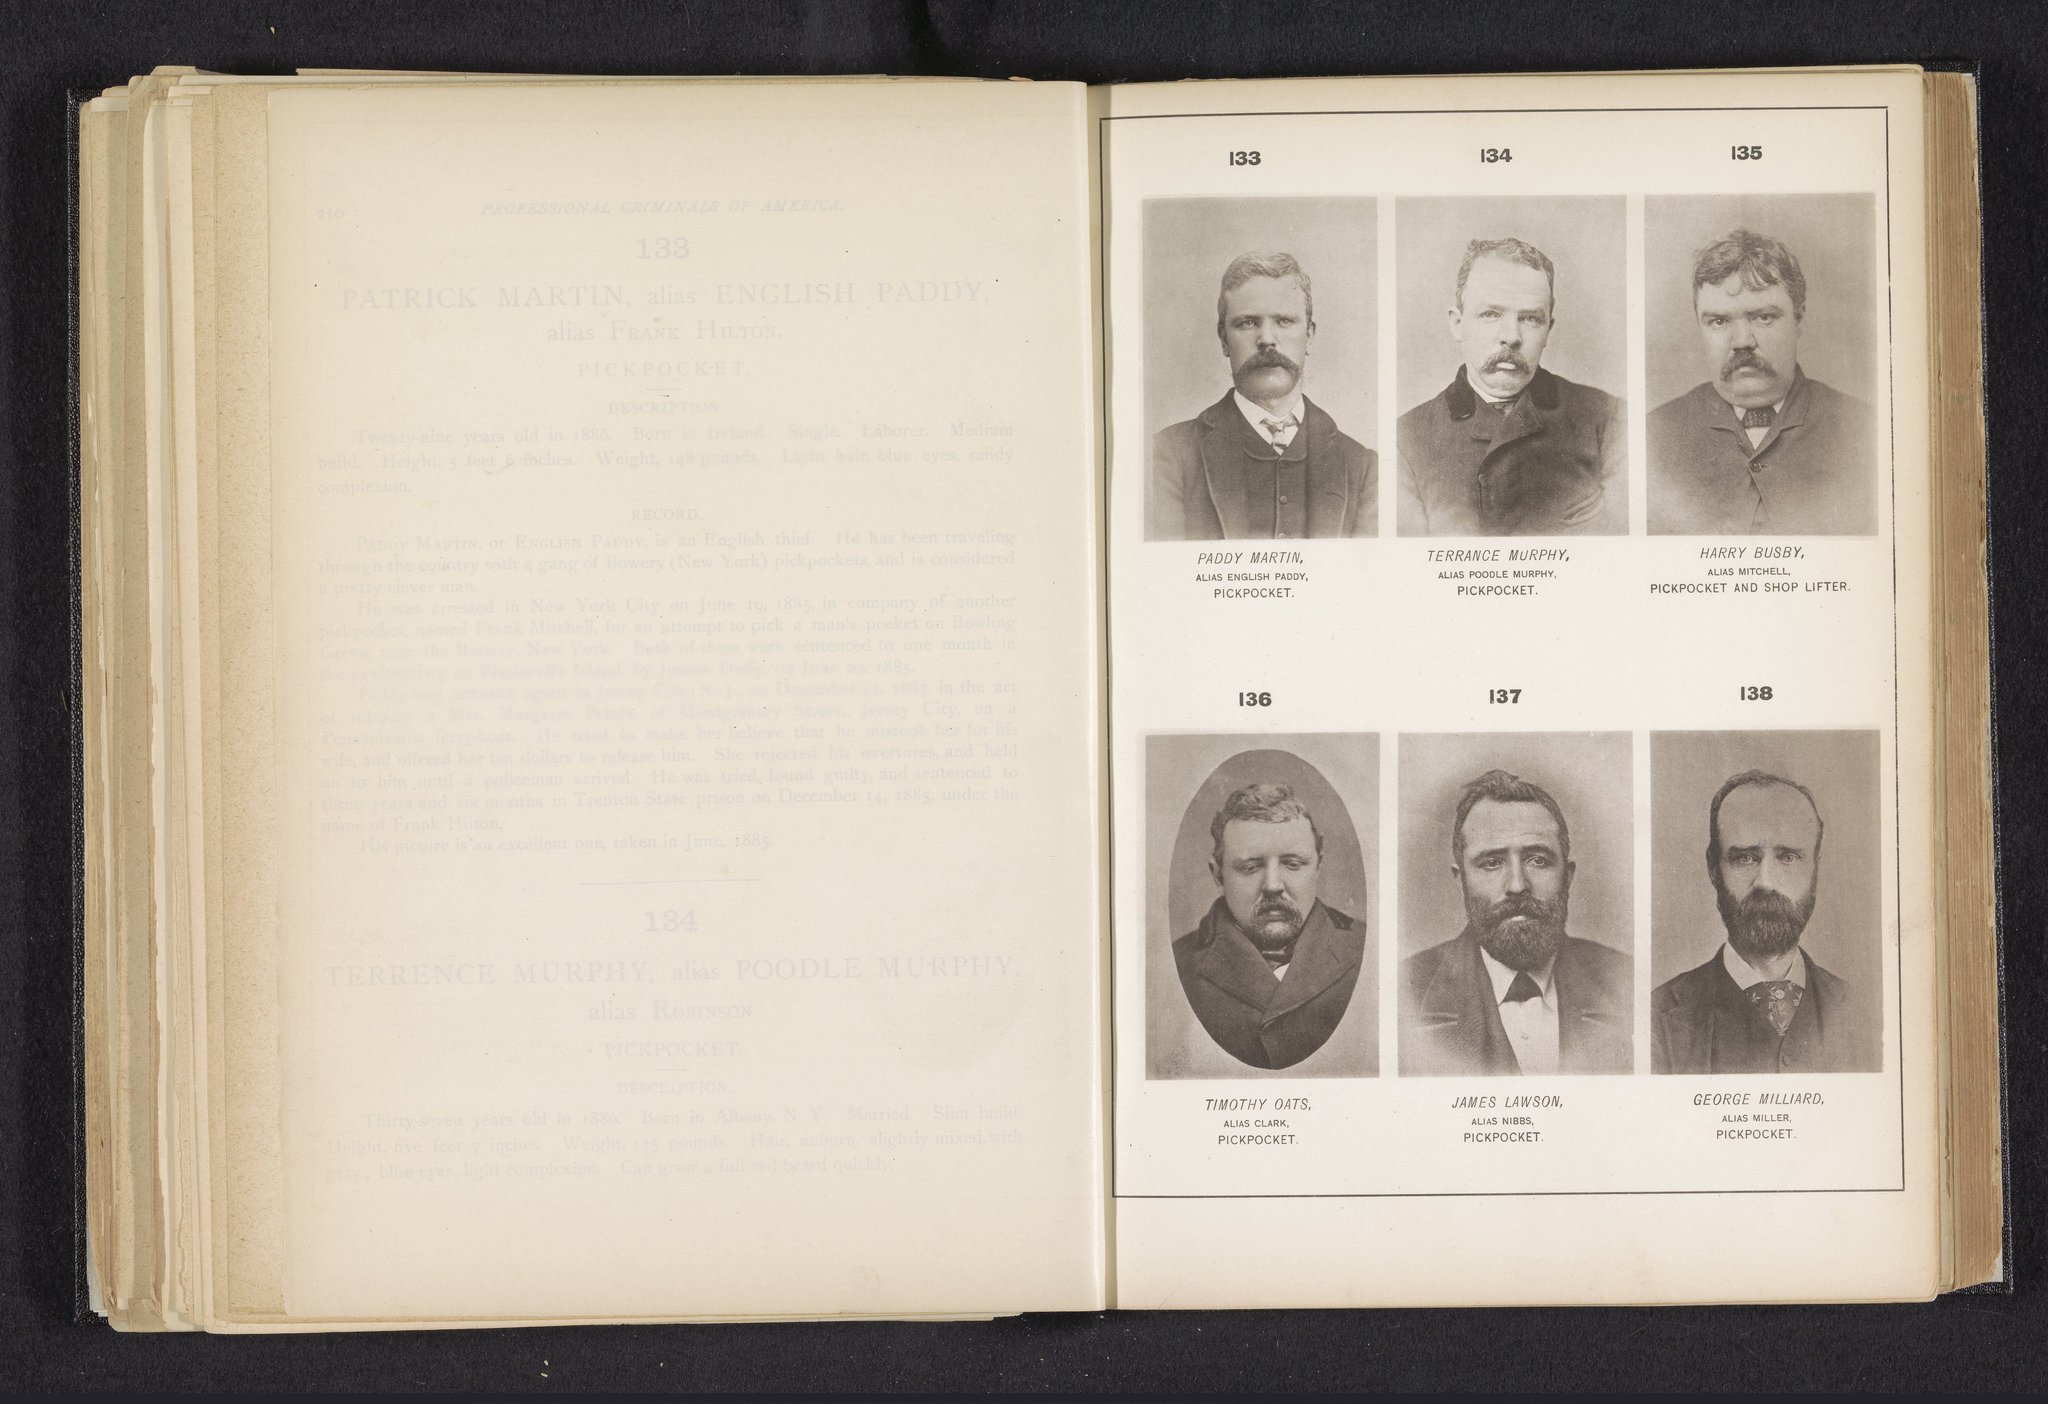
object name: photomechanical print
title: Zes portretten van zakkenrollers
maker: Anonymous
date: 1881-1886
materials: paper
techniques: photograph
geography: boston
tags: historical persons not known by name (+ (full) bust portrait), pickpocket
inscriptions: inscription: ‘Paddy Martin (...) pickpocket.’, number: ‘133 (...) 138’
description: Linksboven Paddy Martin, midden boven Terrance Murphy, rechtsboven Harry Busby, linksonder Timothy Oats, midden onder James Lawson, rechtsonder George Milliard.